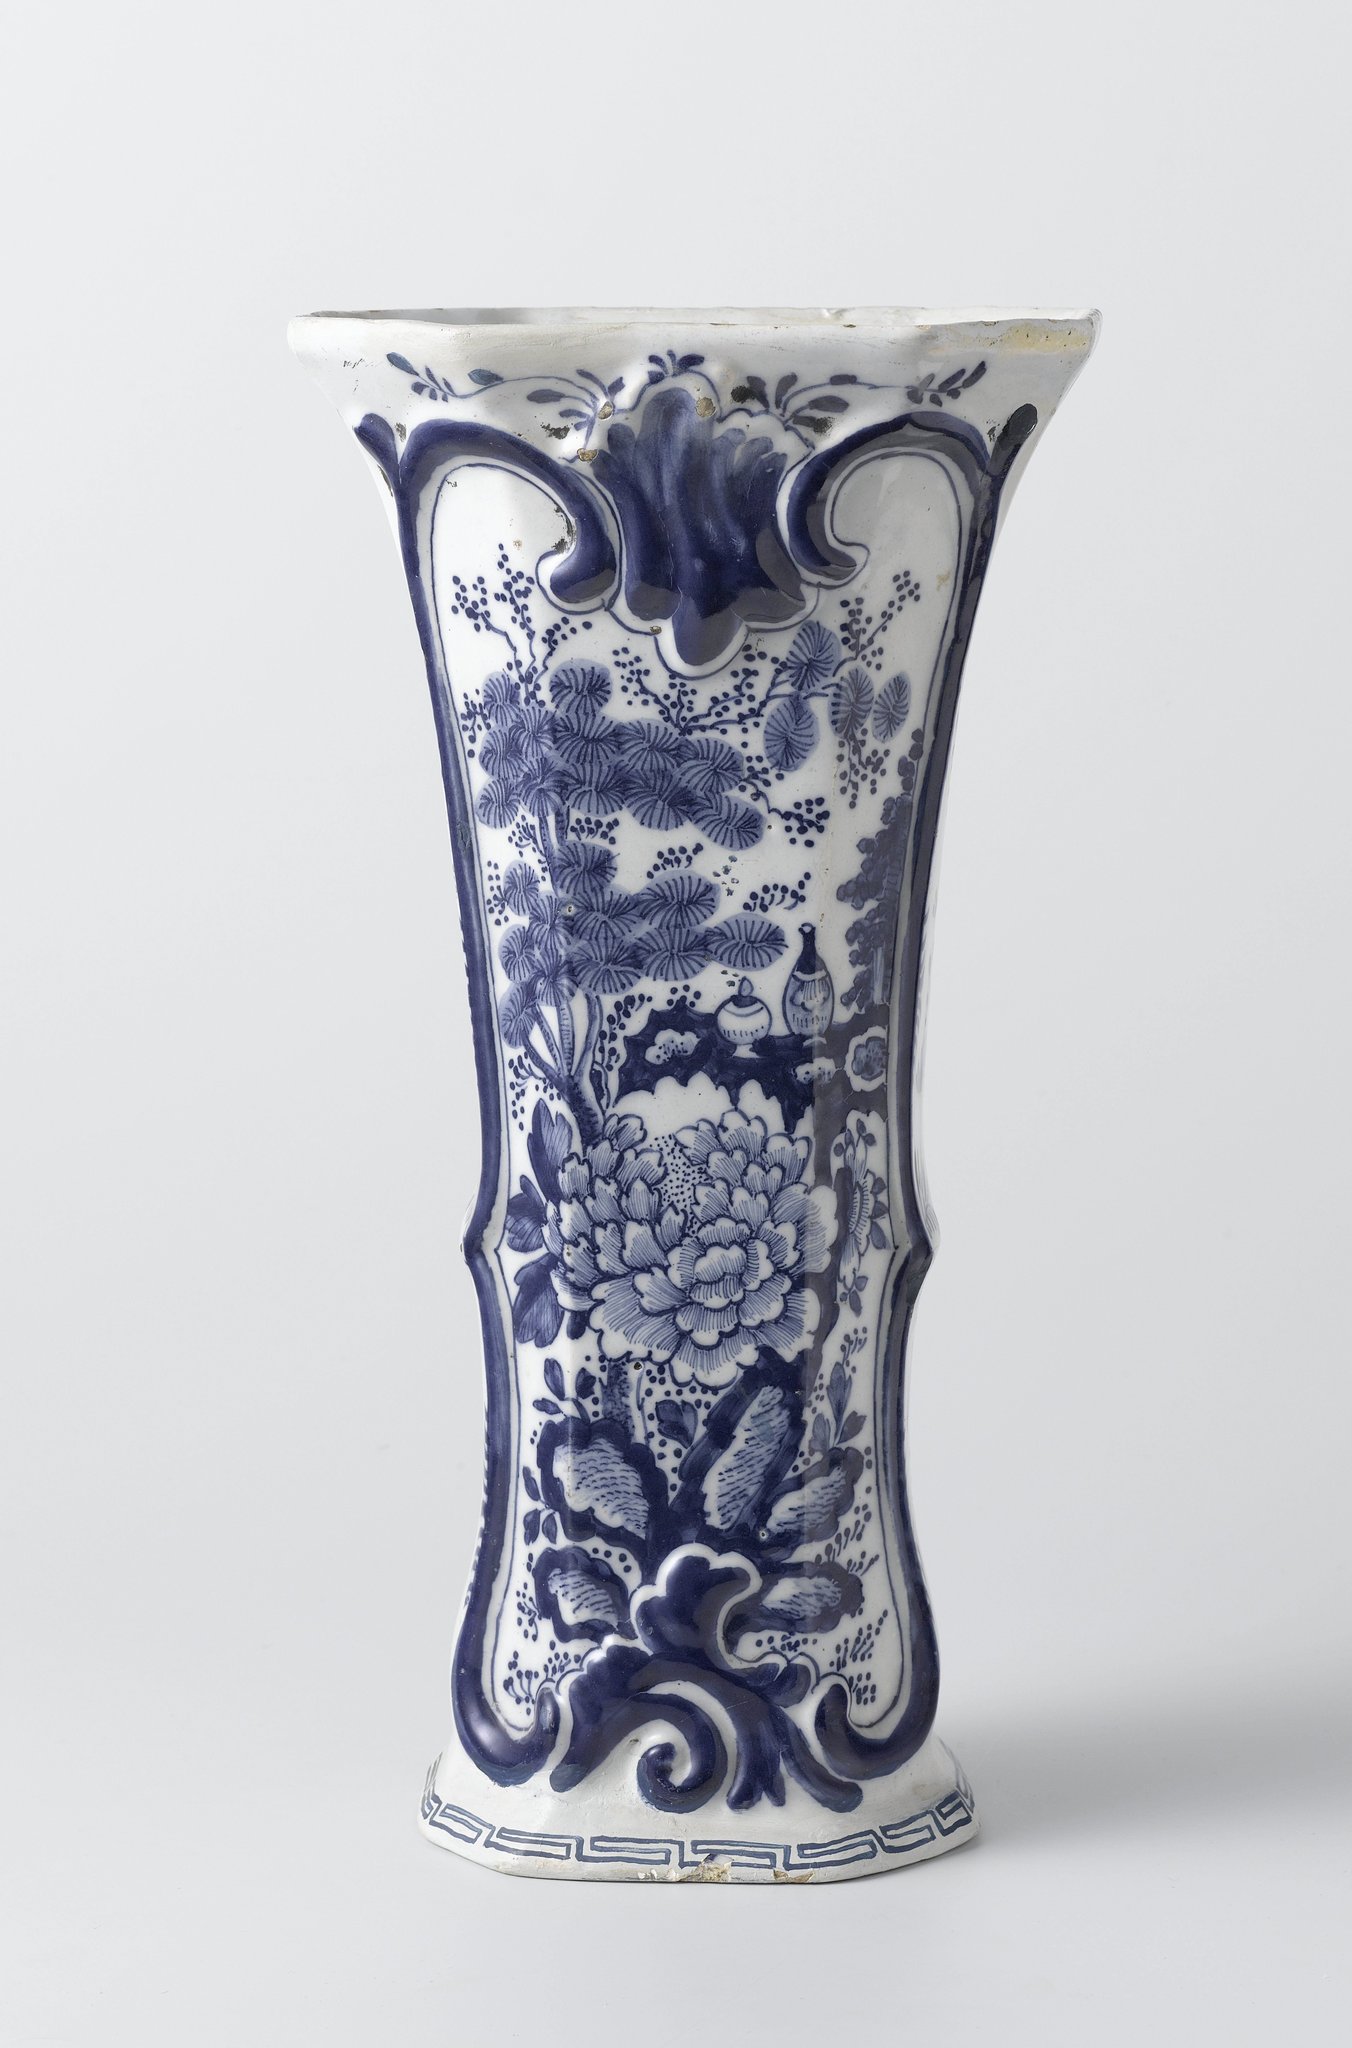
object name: kaststel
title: Two beaker vases and a vase, part of a garniture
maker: lambertus sanderus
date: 1760-1800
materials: earthenware, glaze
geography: delft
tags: flowers ~ ornament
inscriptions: mark: ‘figuratief teken klauw/ onleesbaar figuratief teken’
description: attributed to De Klaauw (Lambertus Sanderus) Delft, c. 1760–1800 tin-glazed earthenware (faience)